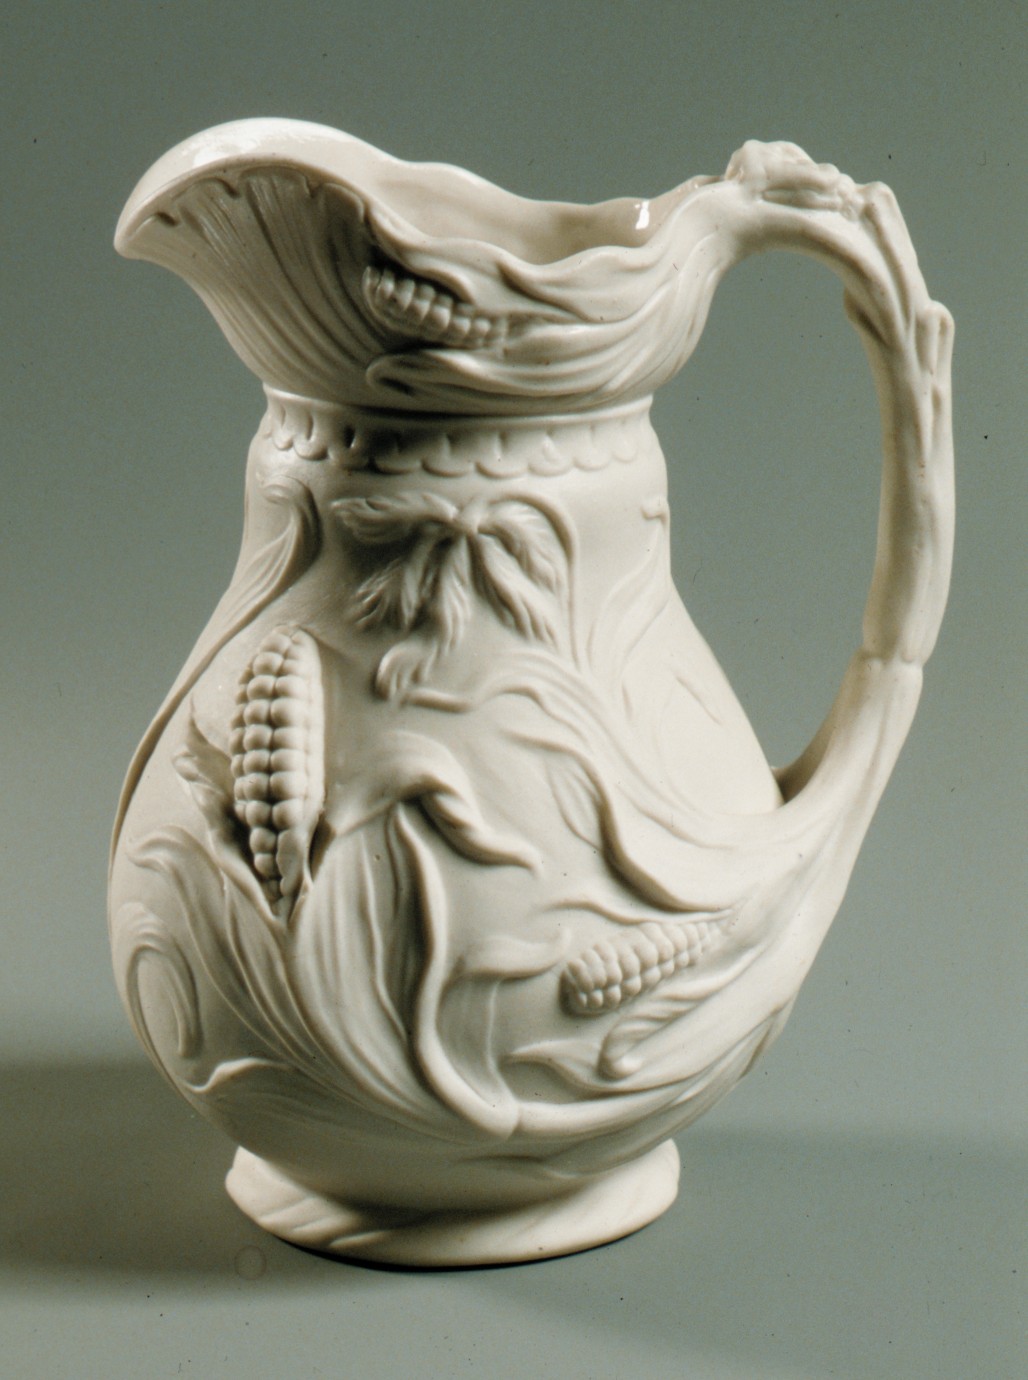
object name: pitcher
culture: american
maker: united states pottery company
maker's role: maker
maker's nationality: american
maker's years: 1852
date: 1850-1858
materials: porcelain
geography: united states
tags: corn